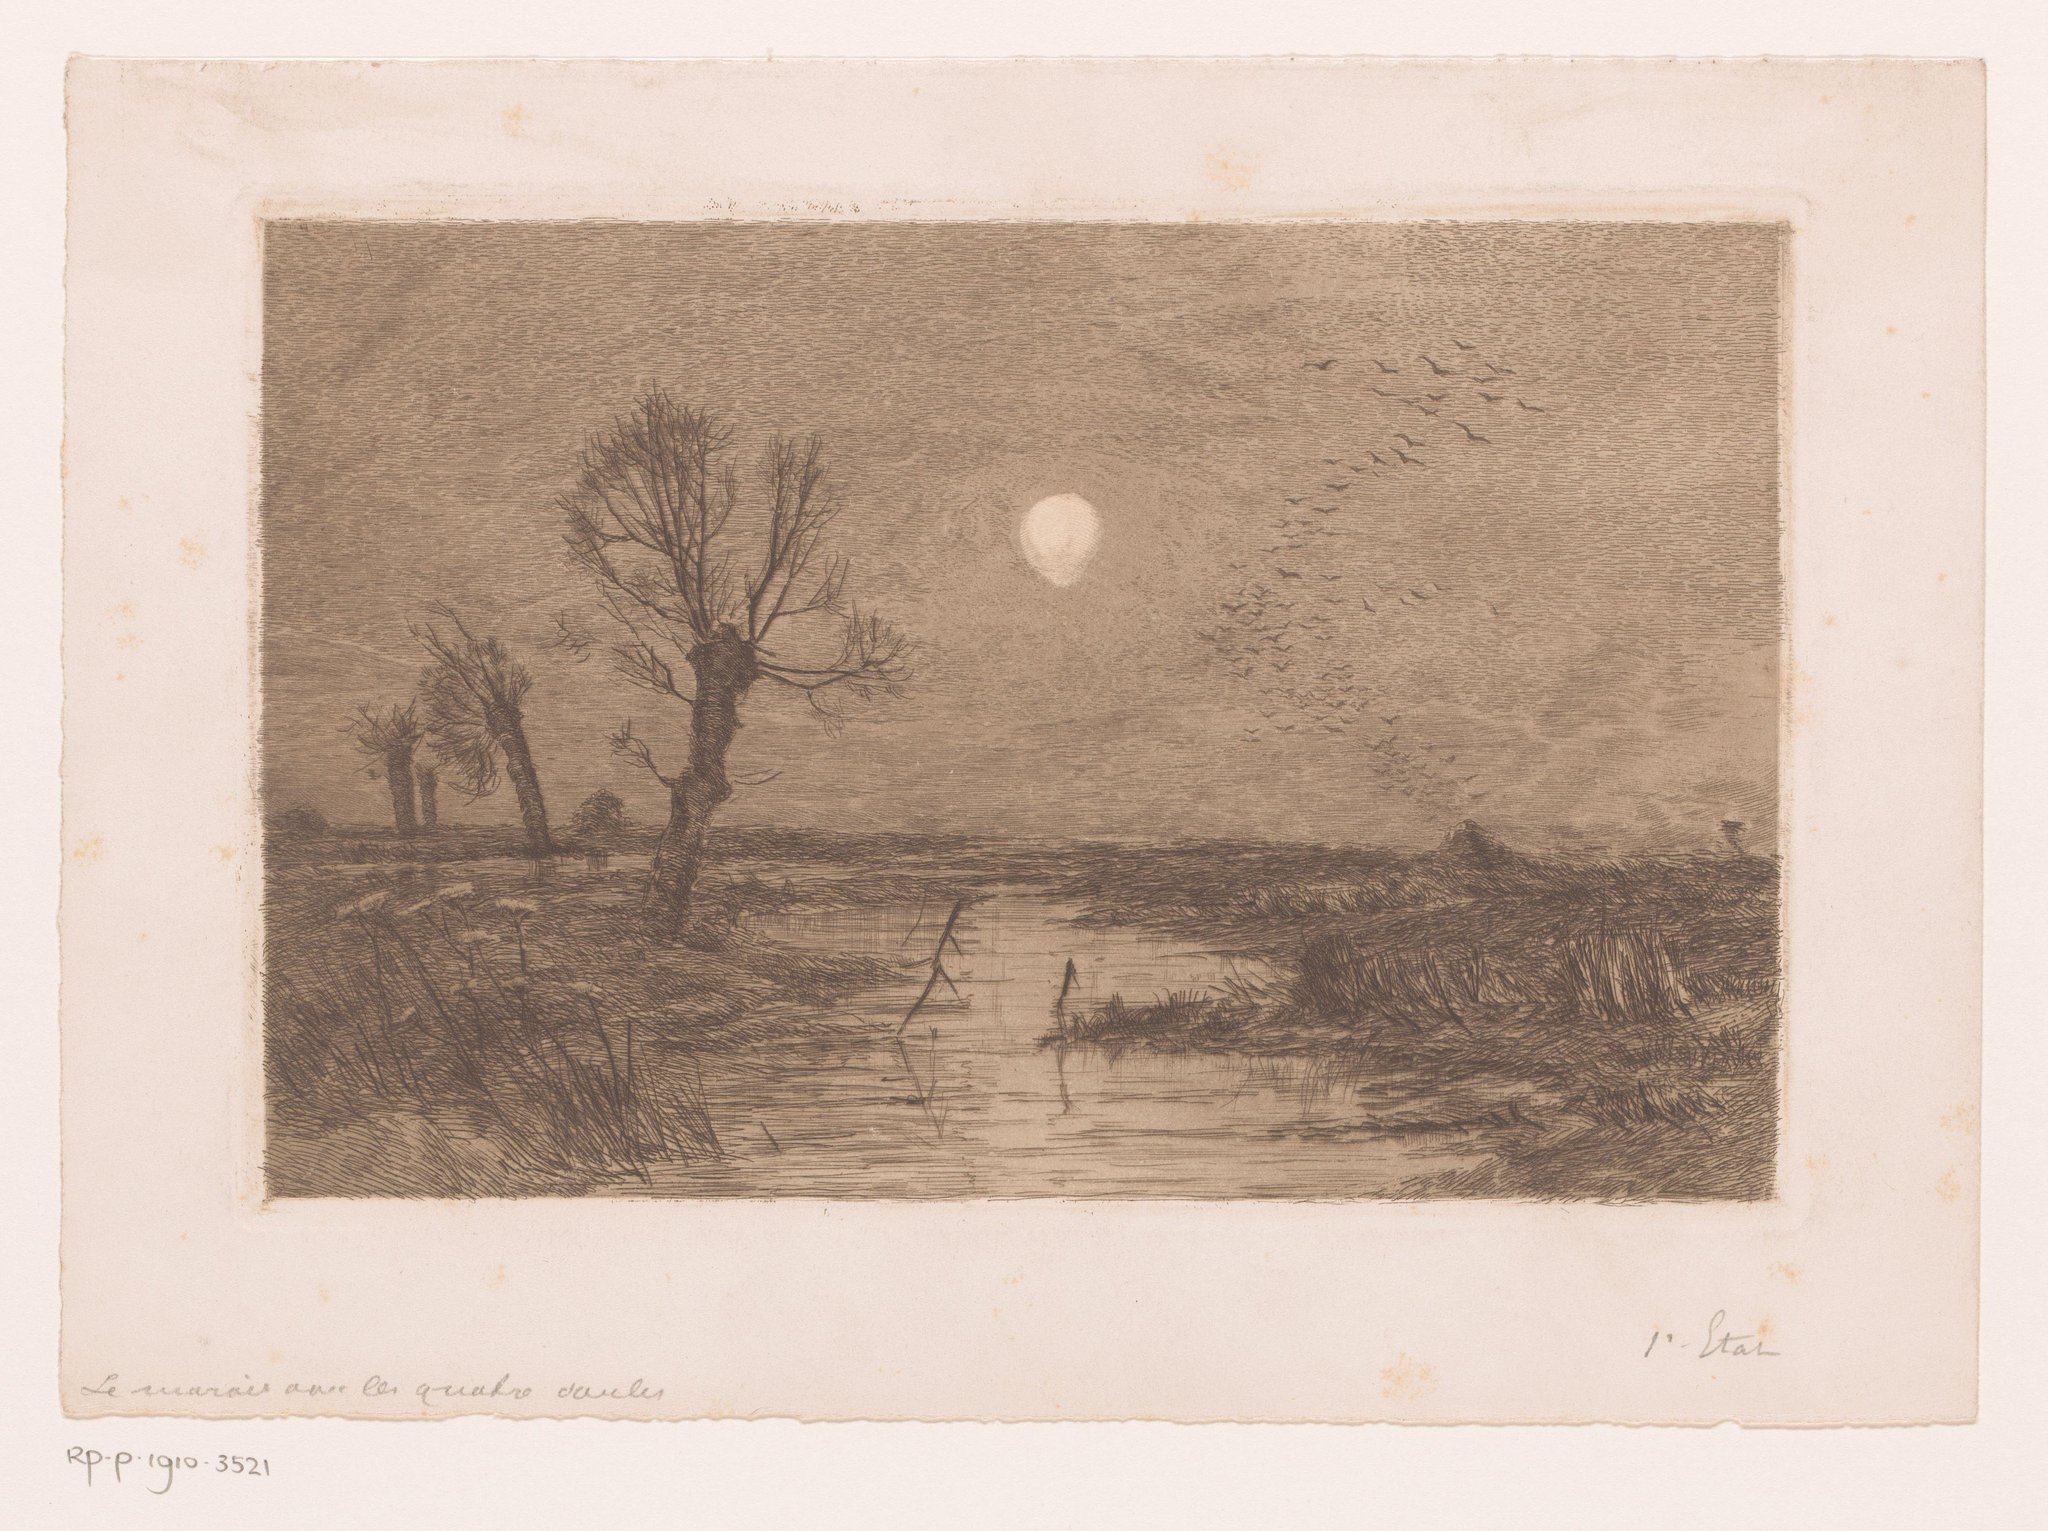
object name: print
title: Moeras met vier wilgen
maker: jules guiette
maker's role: print maker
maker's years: 1852-1901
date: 1862-1901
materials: paper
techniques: etching, intaglio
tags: swamp, inland marsh, fens, trees: willow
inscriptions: annotation: ‘Le marais avec les quatre saules; 1er Etat’, collector's mark: Lugt 2228